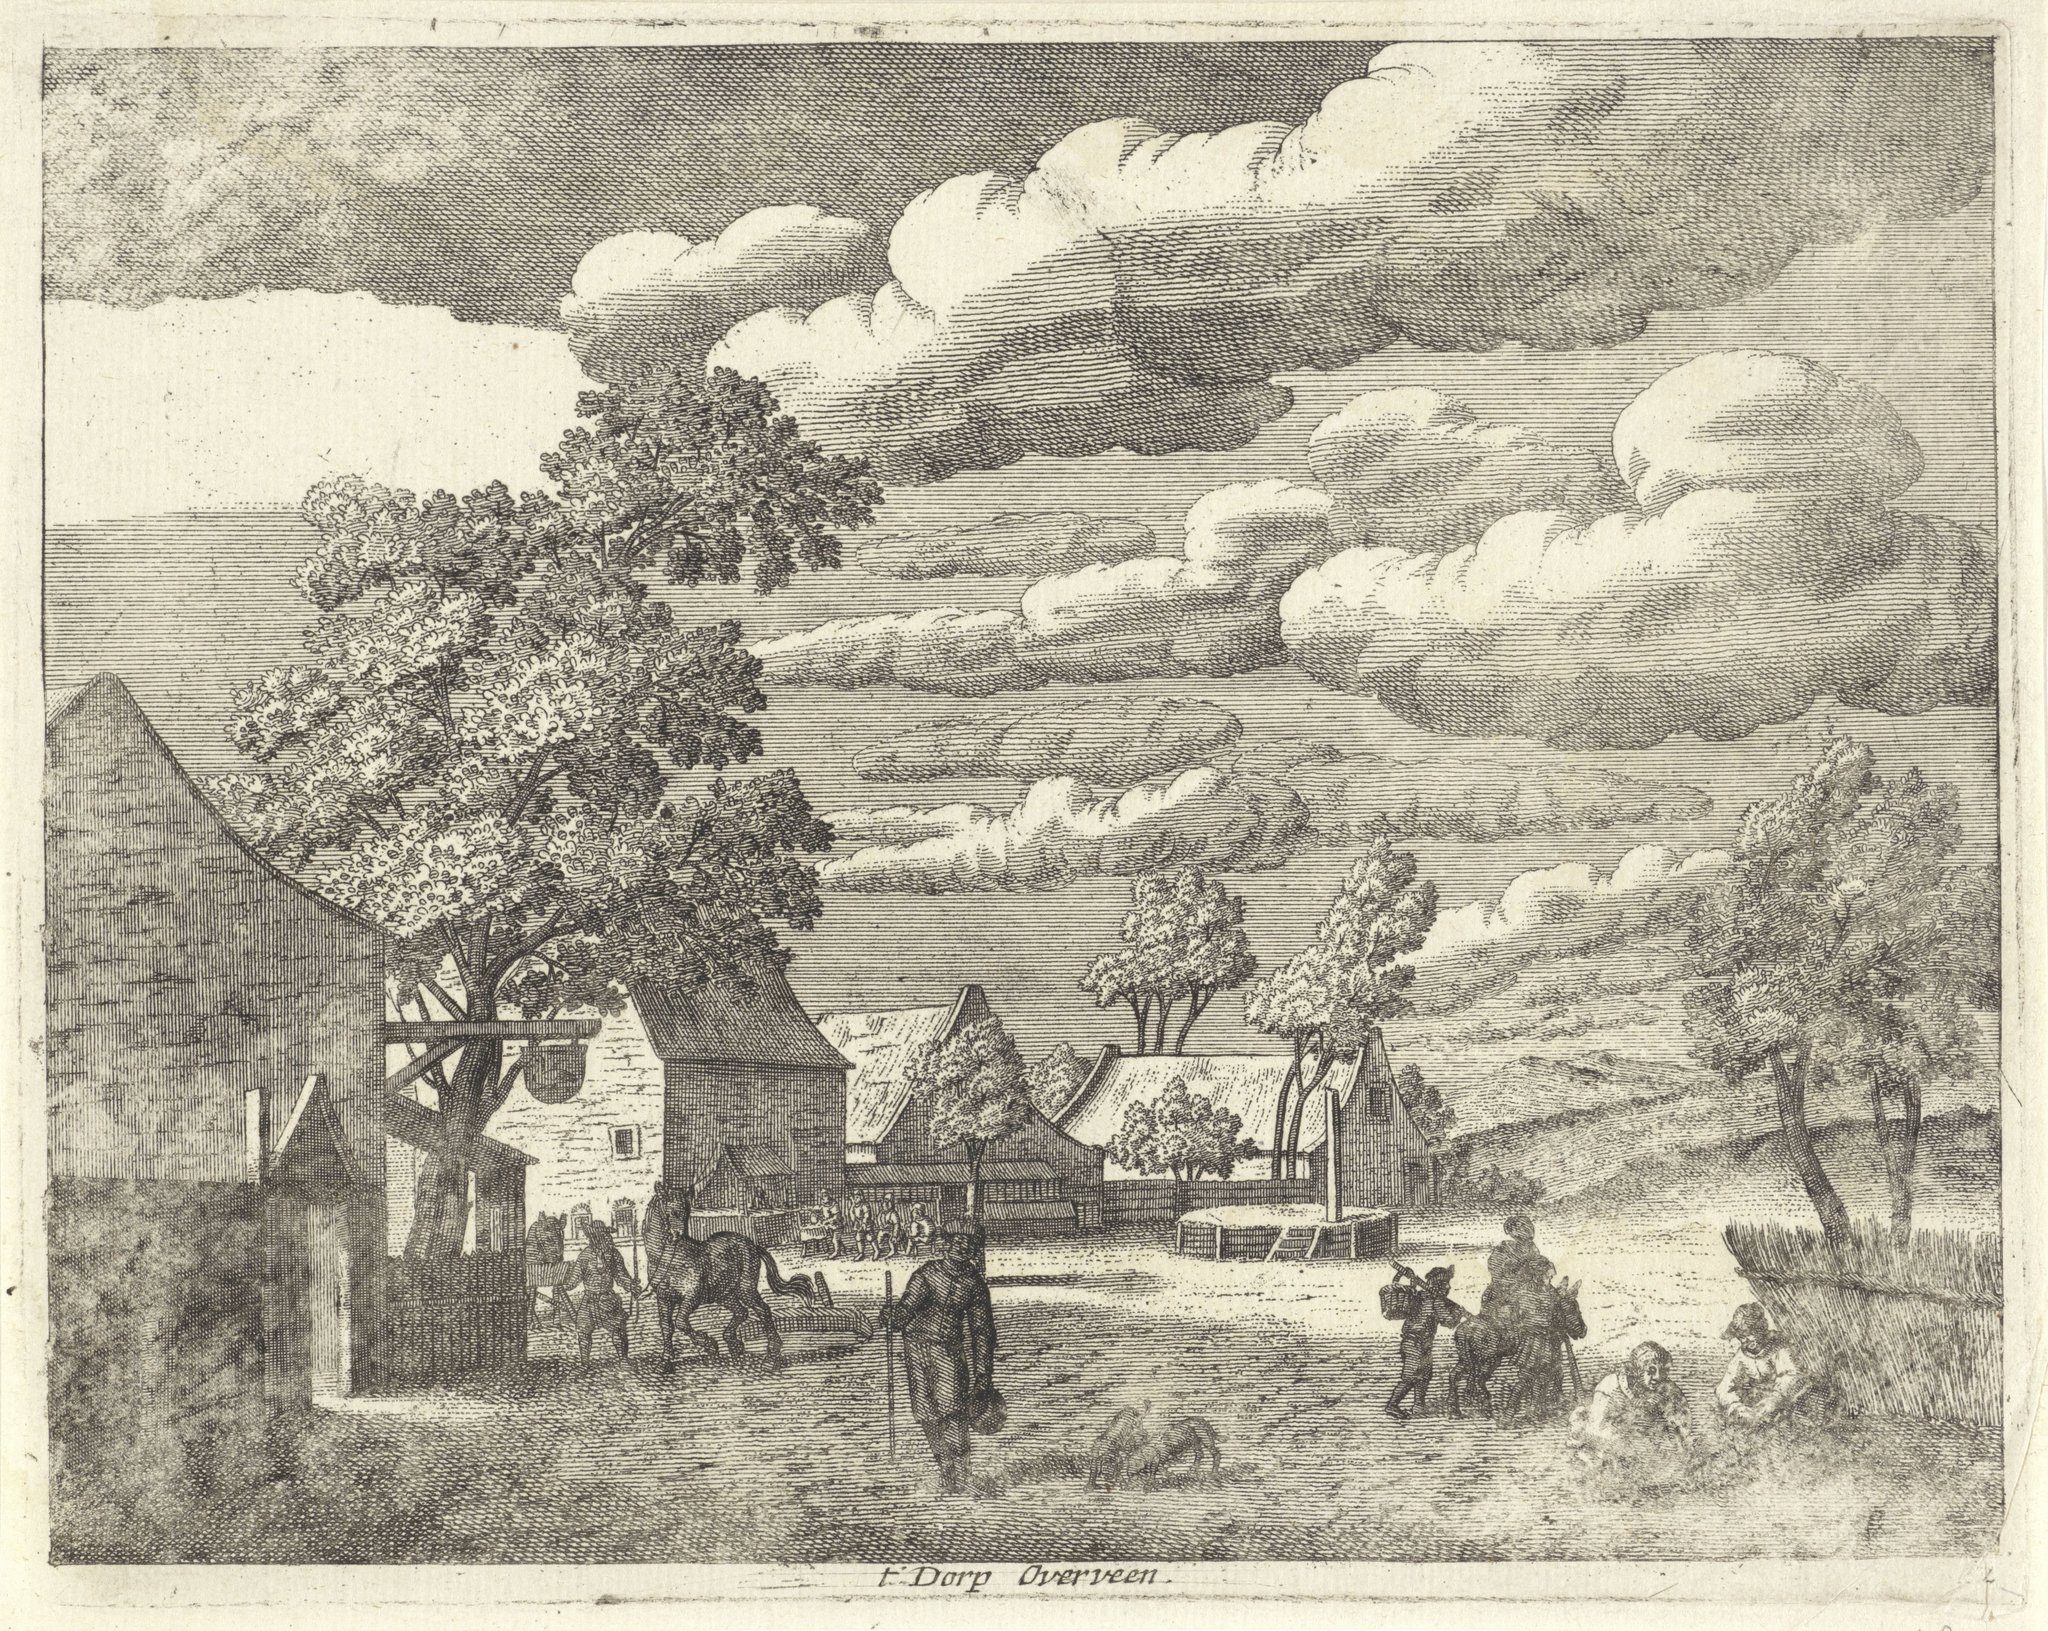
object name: print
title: Gezicht op Overveen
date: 1690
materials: paper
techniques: etching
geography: amsterdam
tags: hotel, hostelry, inn, village square, place (+ city(-scape) with figures, staffage)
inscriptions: collector's mark: Lugt 2228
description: Huizen en een herberg aan een weg te Overveen. Op de voorgrond verschillende figuren en dieren.